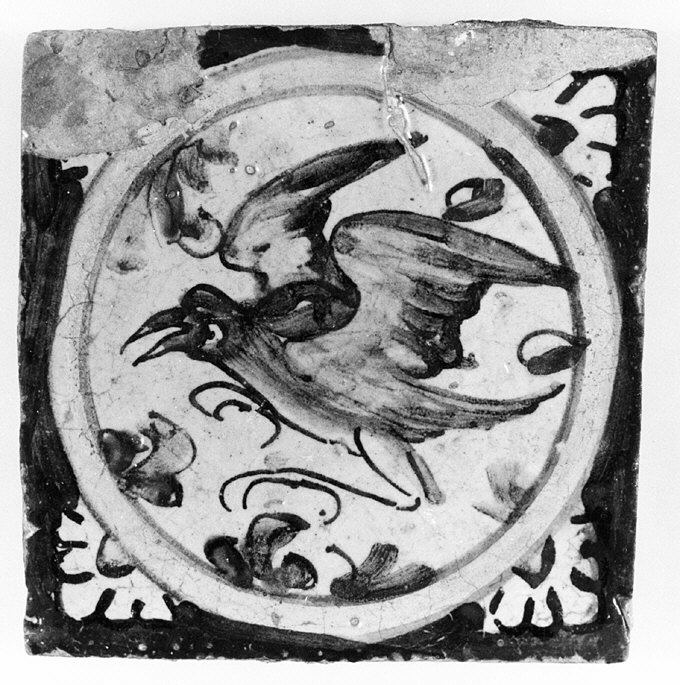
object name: wall tile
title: Set of four wall tiles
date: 1601-1800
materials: earthenware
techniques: glazing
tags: birds